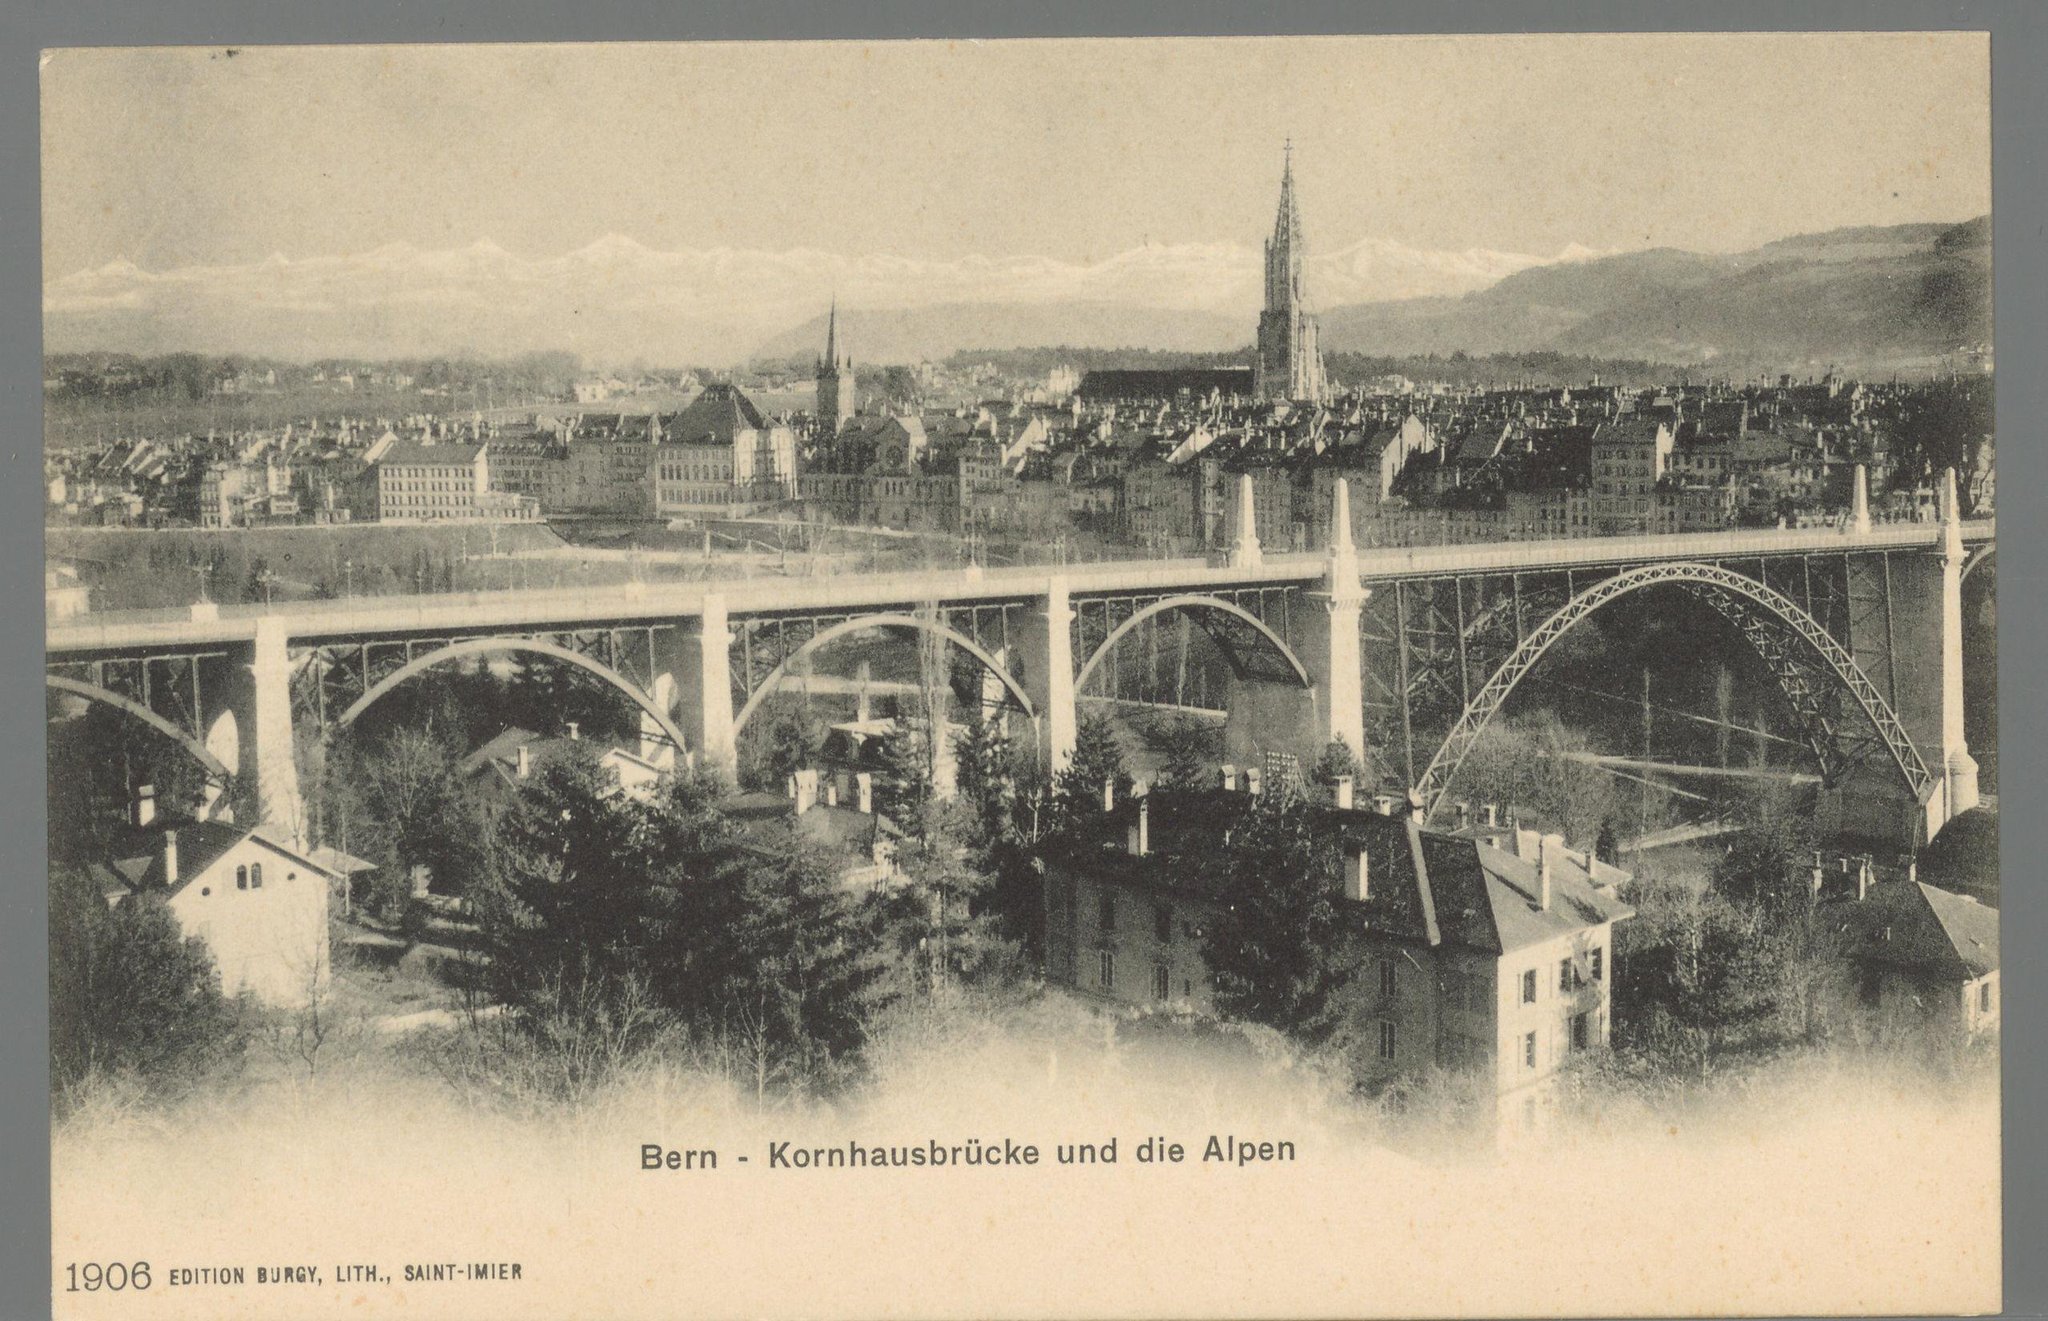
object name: ansichtkaart, prentbriefkaart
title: Bern. Kornhausbrücke und die Alpen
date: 1897-1905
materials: cardboard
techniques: photograph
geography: saint-imier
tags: church (exterior), mountain-range, snow peaks, prospect of city, town panorama, silhouette of city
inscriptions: stamp: ‘A.G.H.’